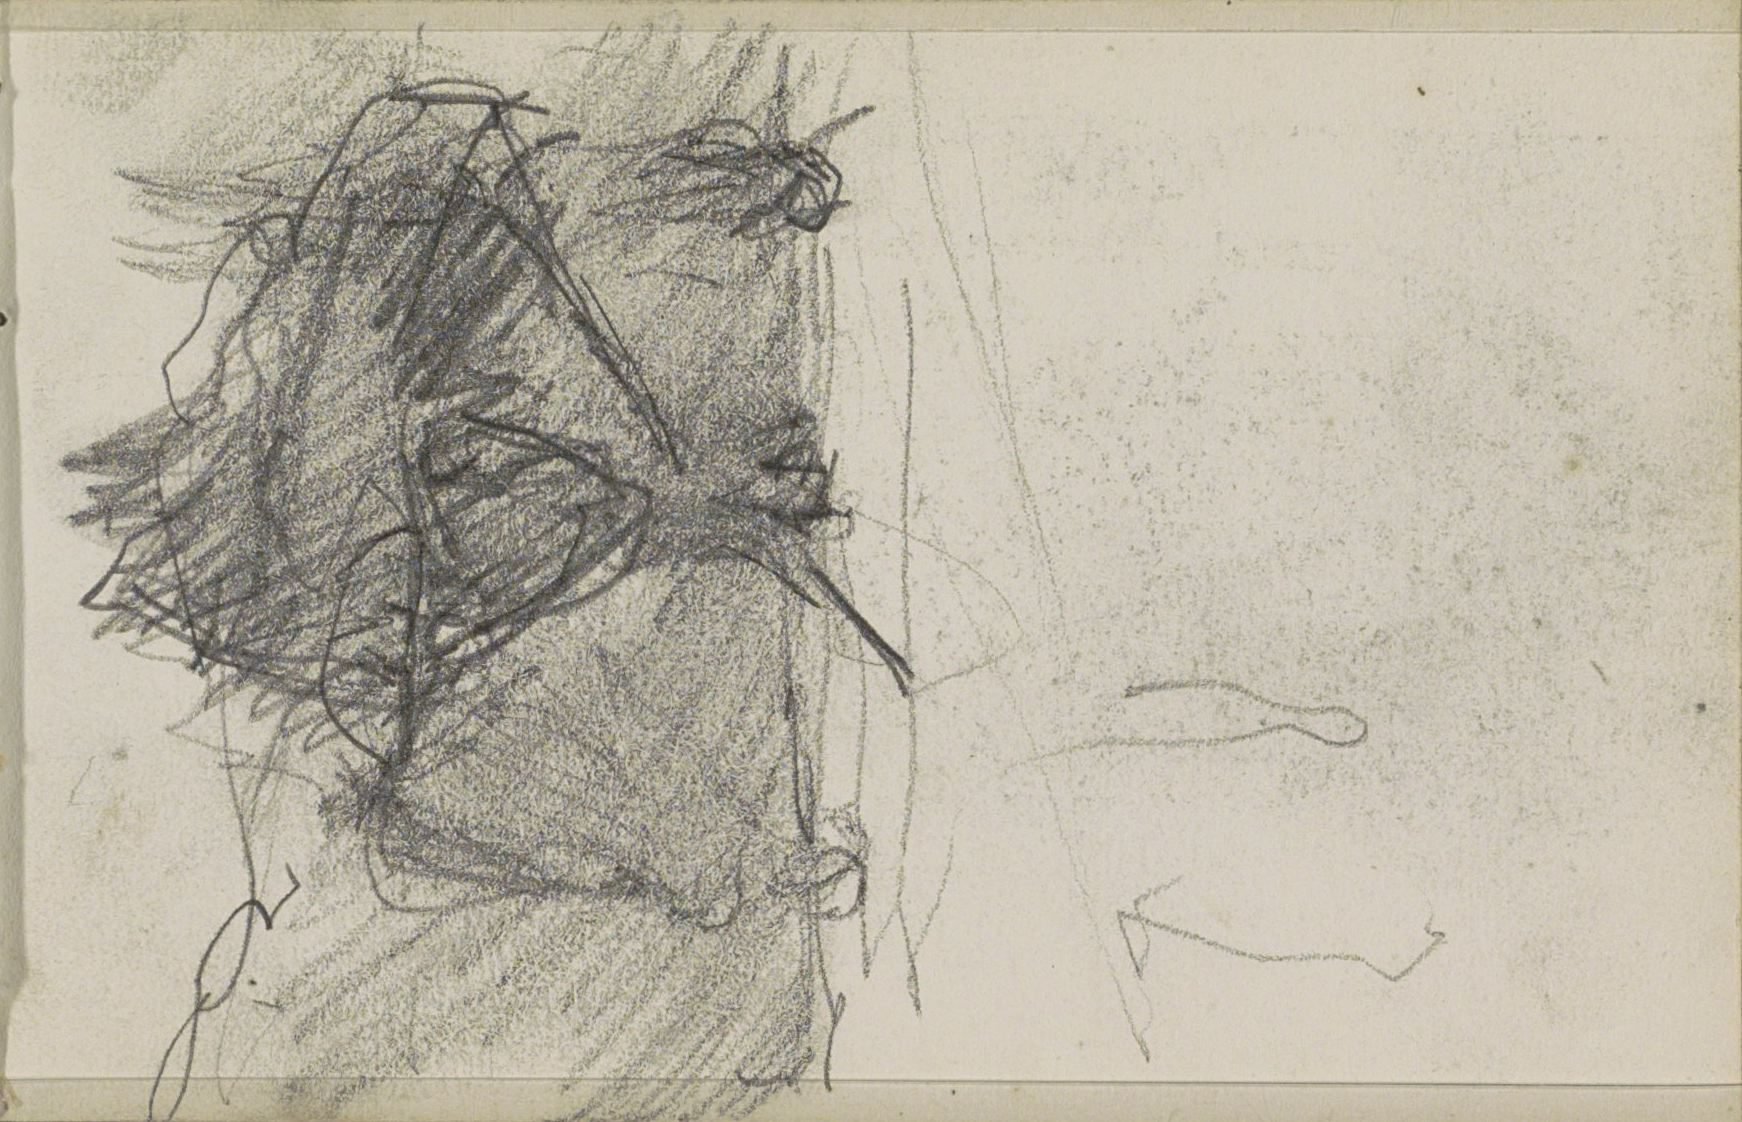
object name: sketchbook leaf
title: Studie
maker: george clausen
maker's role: draughtsman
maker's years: 1852-1912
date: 1875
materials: paper, pencil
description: Blad 13 recto uit een schetsboek met 38 bladen.